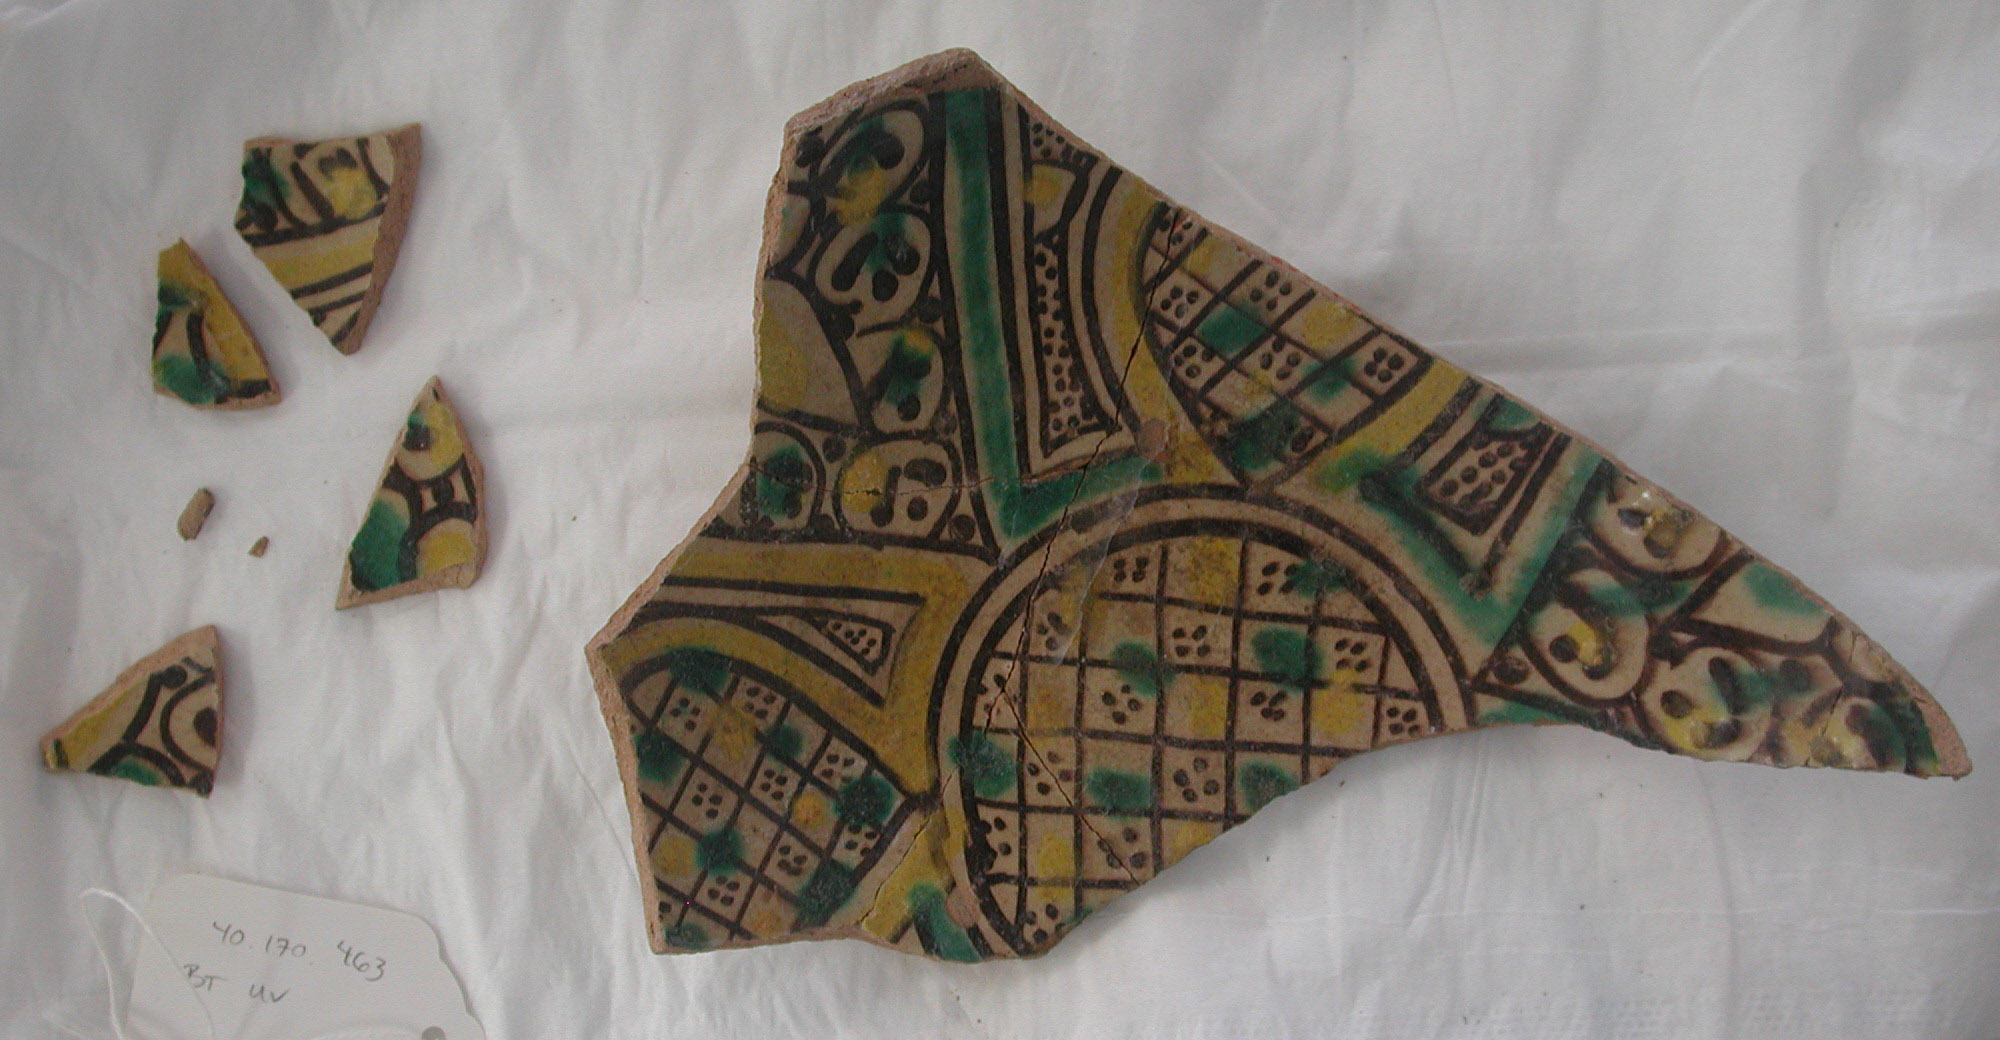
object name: fragment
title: Fragments of a Bowl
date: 1101-1200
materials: earthenware, glaze, pigment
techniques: painting, polychrome, underglaze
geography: iran